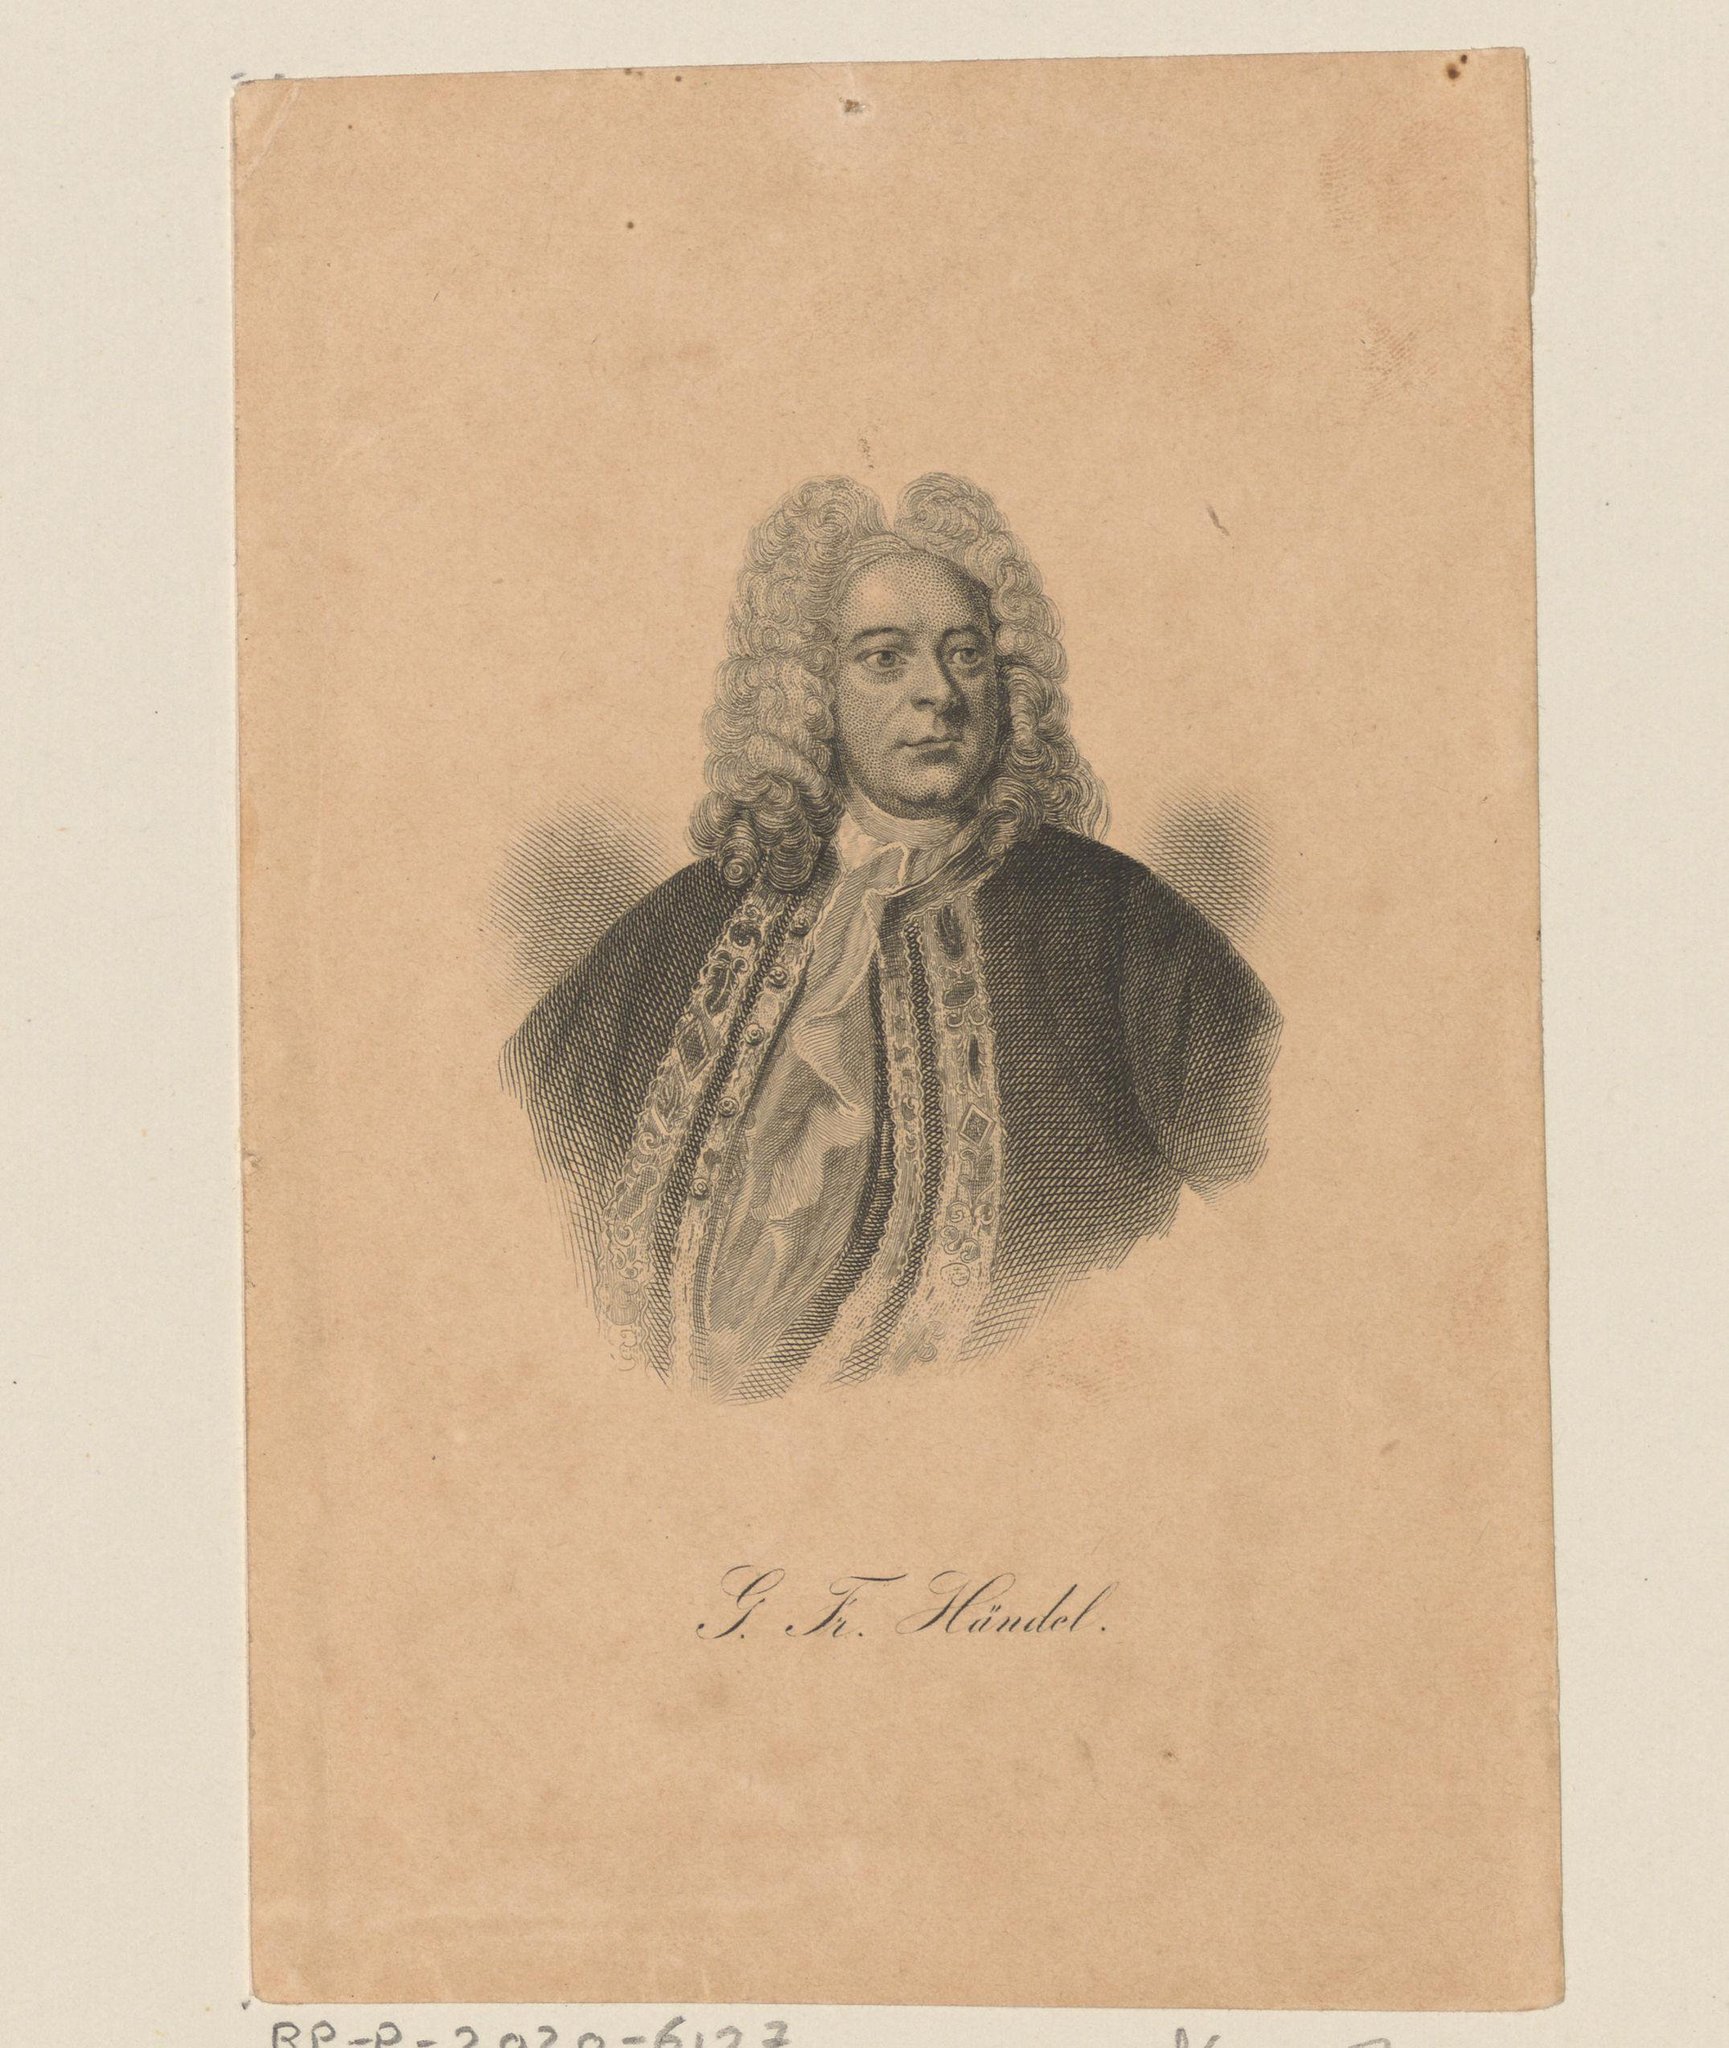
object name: print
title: Portret van Georg Friedrich Händel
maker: Anonymous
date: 1725-1774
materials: paper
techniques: engraving, etching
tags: london, historical persons, portrait of composer